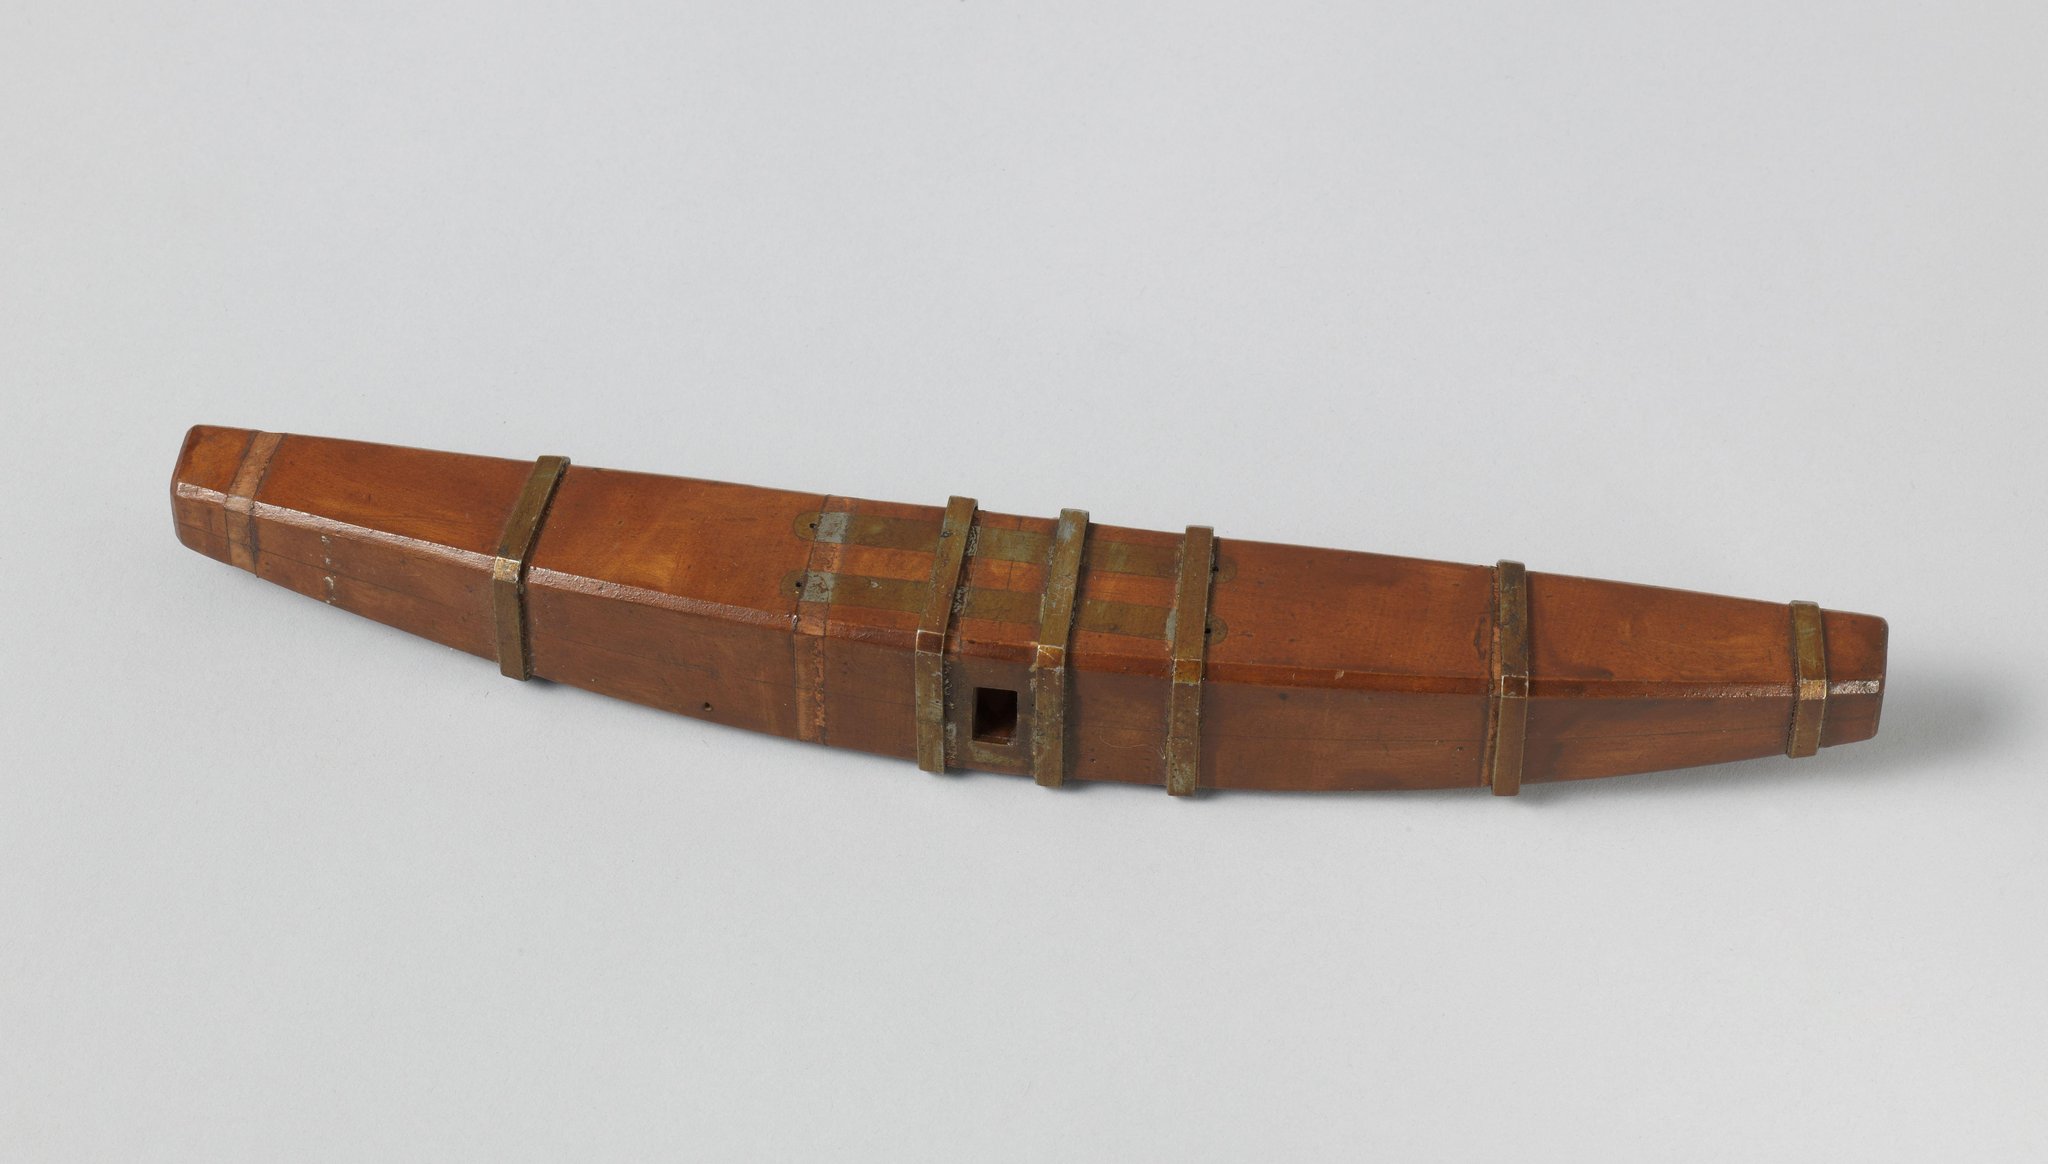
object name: instruction model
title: Model of an Anchor Stock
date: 1863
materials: iron, wood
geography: amsterdam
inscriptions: inscription, on a handwritten note: ‘De model houten ankerstok onder nº 1139 voorkomende, / is vastgesteld by Resolutie dd 10 December 1863 en na by / de verschillende Directiën der Marine te zyn rondgezonden, op de / Modelkamer gedeponeerd.- / Teekening naar dat model vervaardigd zyn opnieuw / toegezonden aan elk der genoemde Directiën by Resolutie / van den 16 April 1883 LaD nº 46.- / ‘s Gravenhage 17 April 1883 / De HoofdIng.r v. algem dienst / waarn. Adviseurv. Scheepsb. / [...] Beeloo / De Heere Bibliothecaris.’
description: Model van een houten ankerstok samengesteld uit twee helften, bijeengehouden door ijzeren hoepels. Waar de schacht door de stok heenloopt zijn er ijzeren strips tegen de zijkanten en verstevigingen boven en onder rondom het gat.